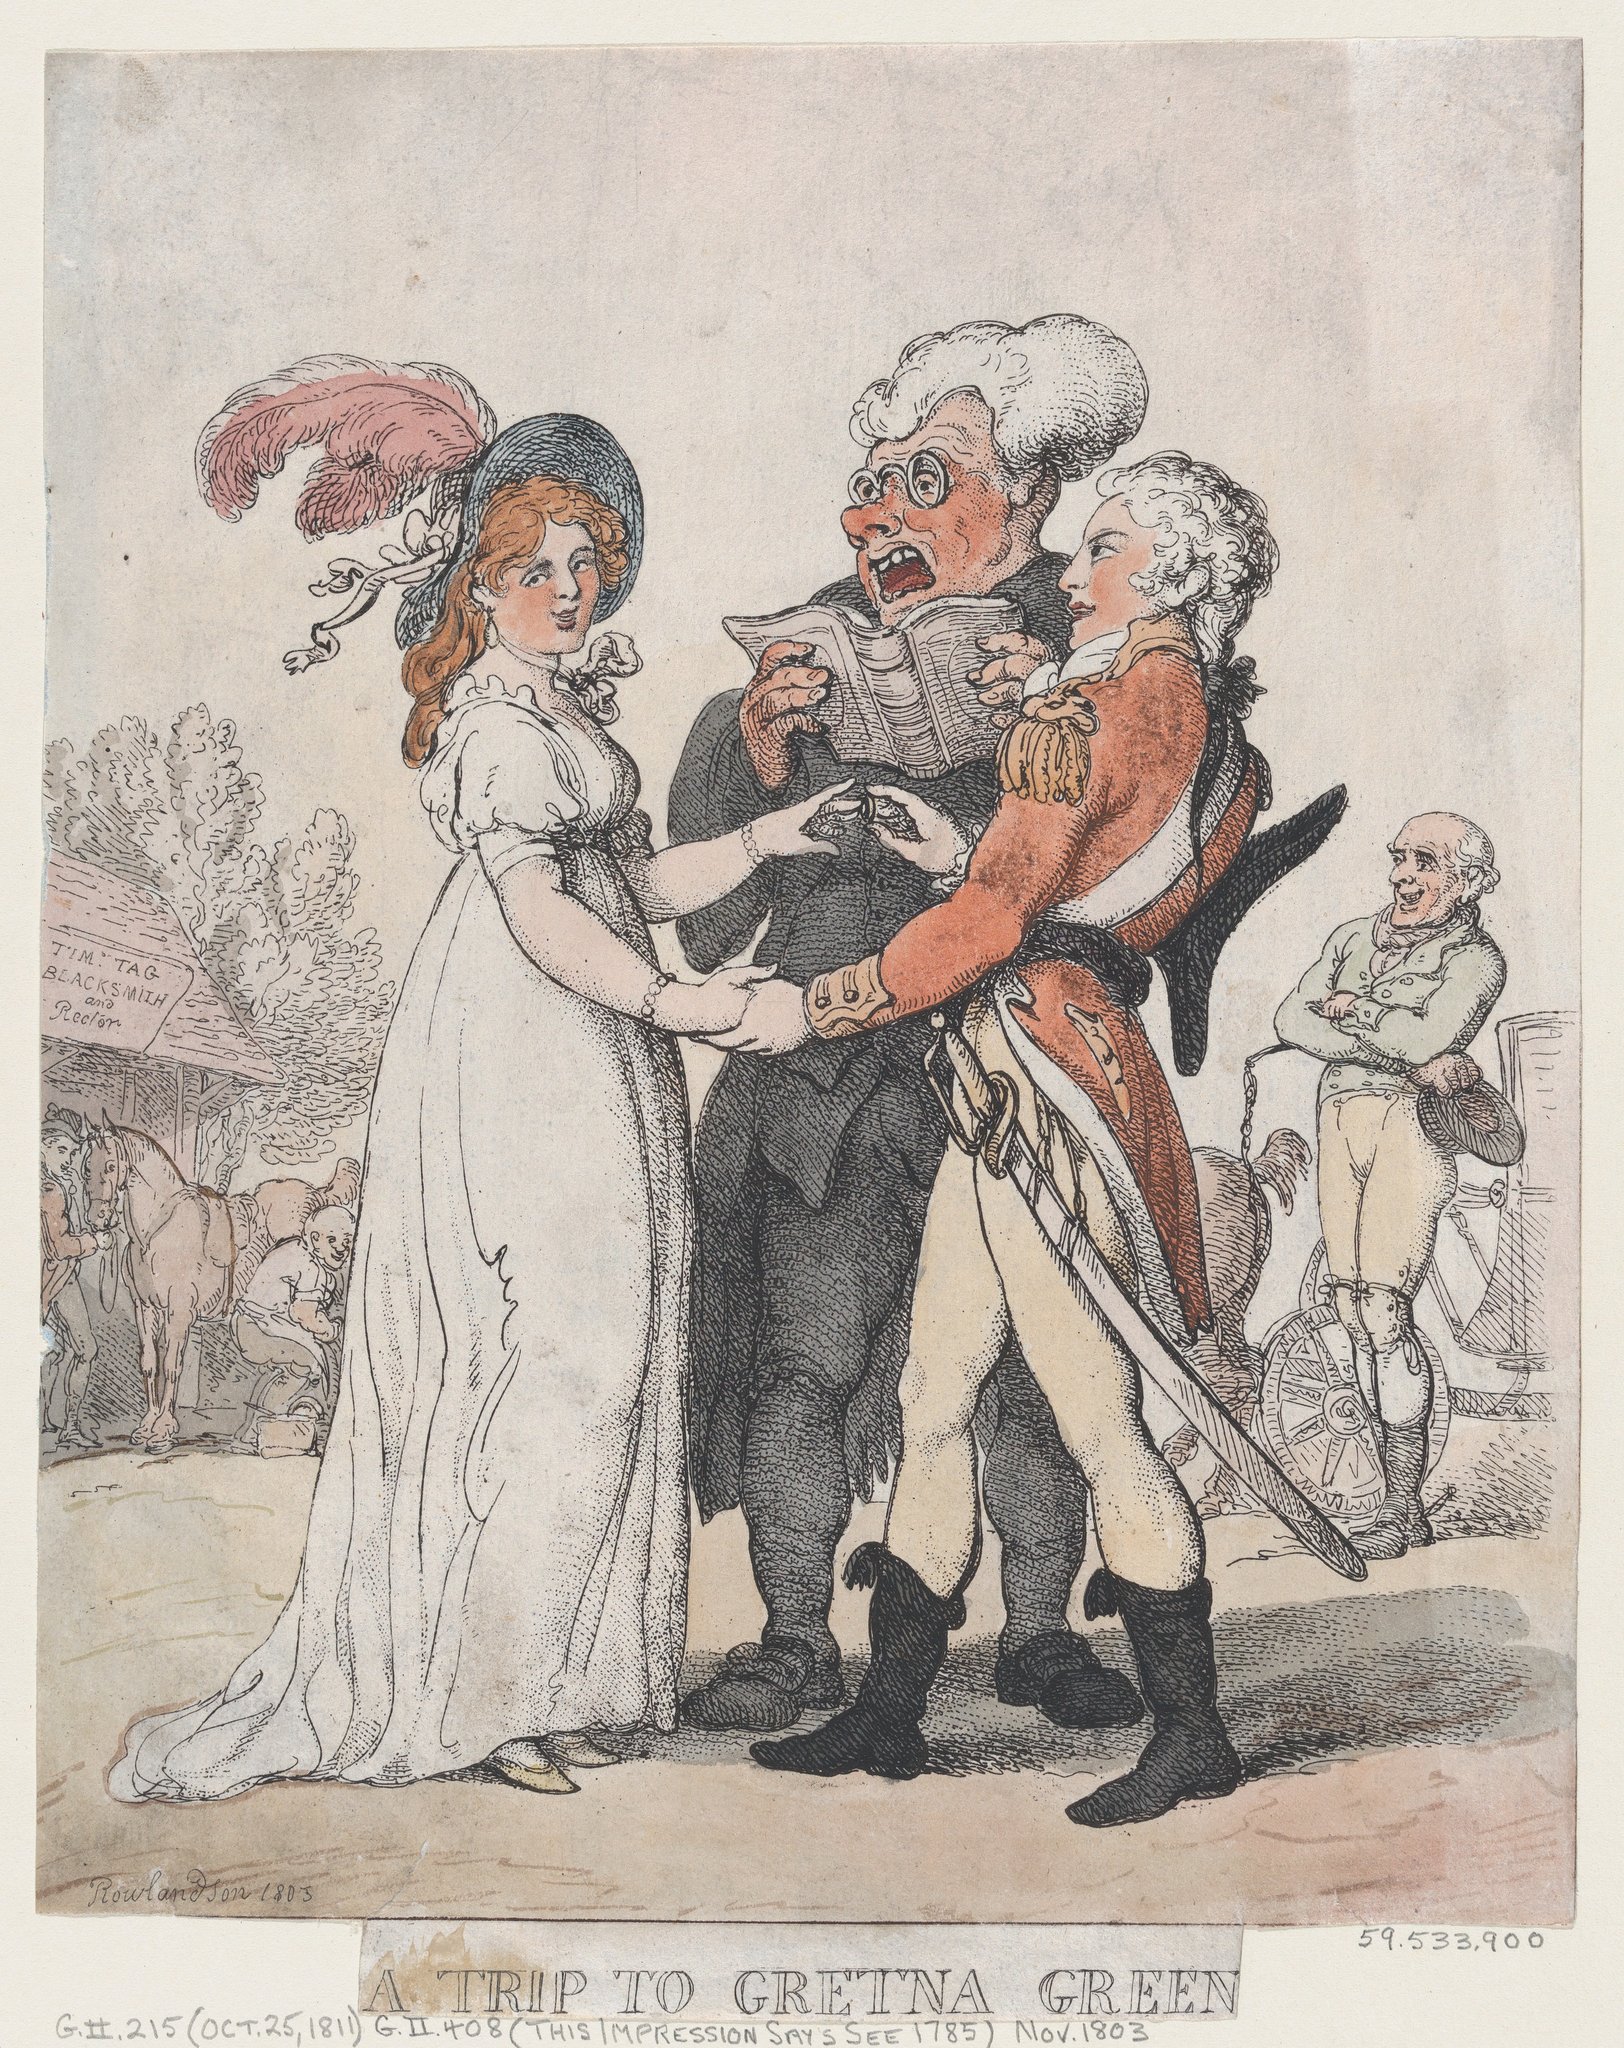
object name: print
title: A Trip to Gretna Green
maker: thomas rowlandson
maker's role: artist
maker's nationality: british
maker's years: 1757-1827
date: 1803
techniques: etching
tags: satire,men,women,weddings